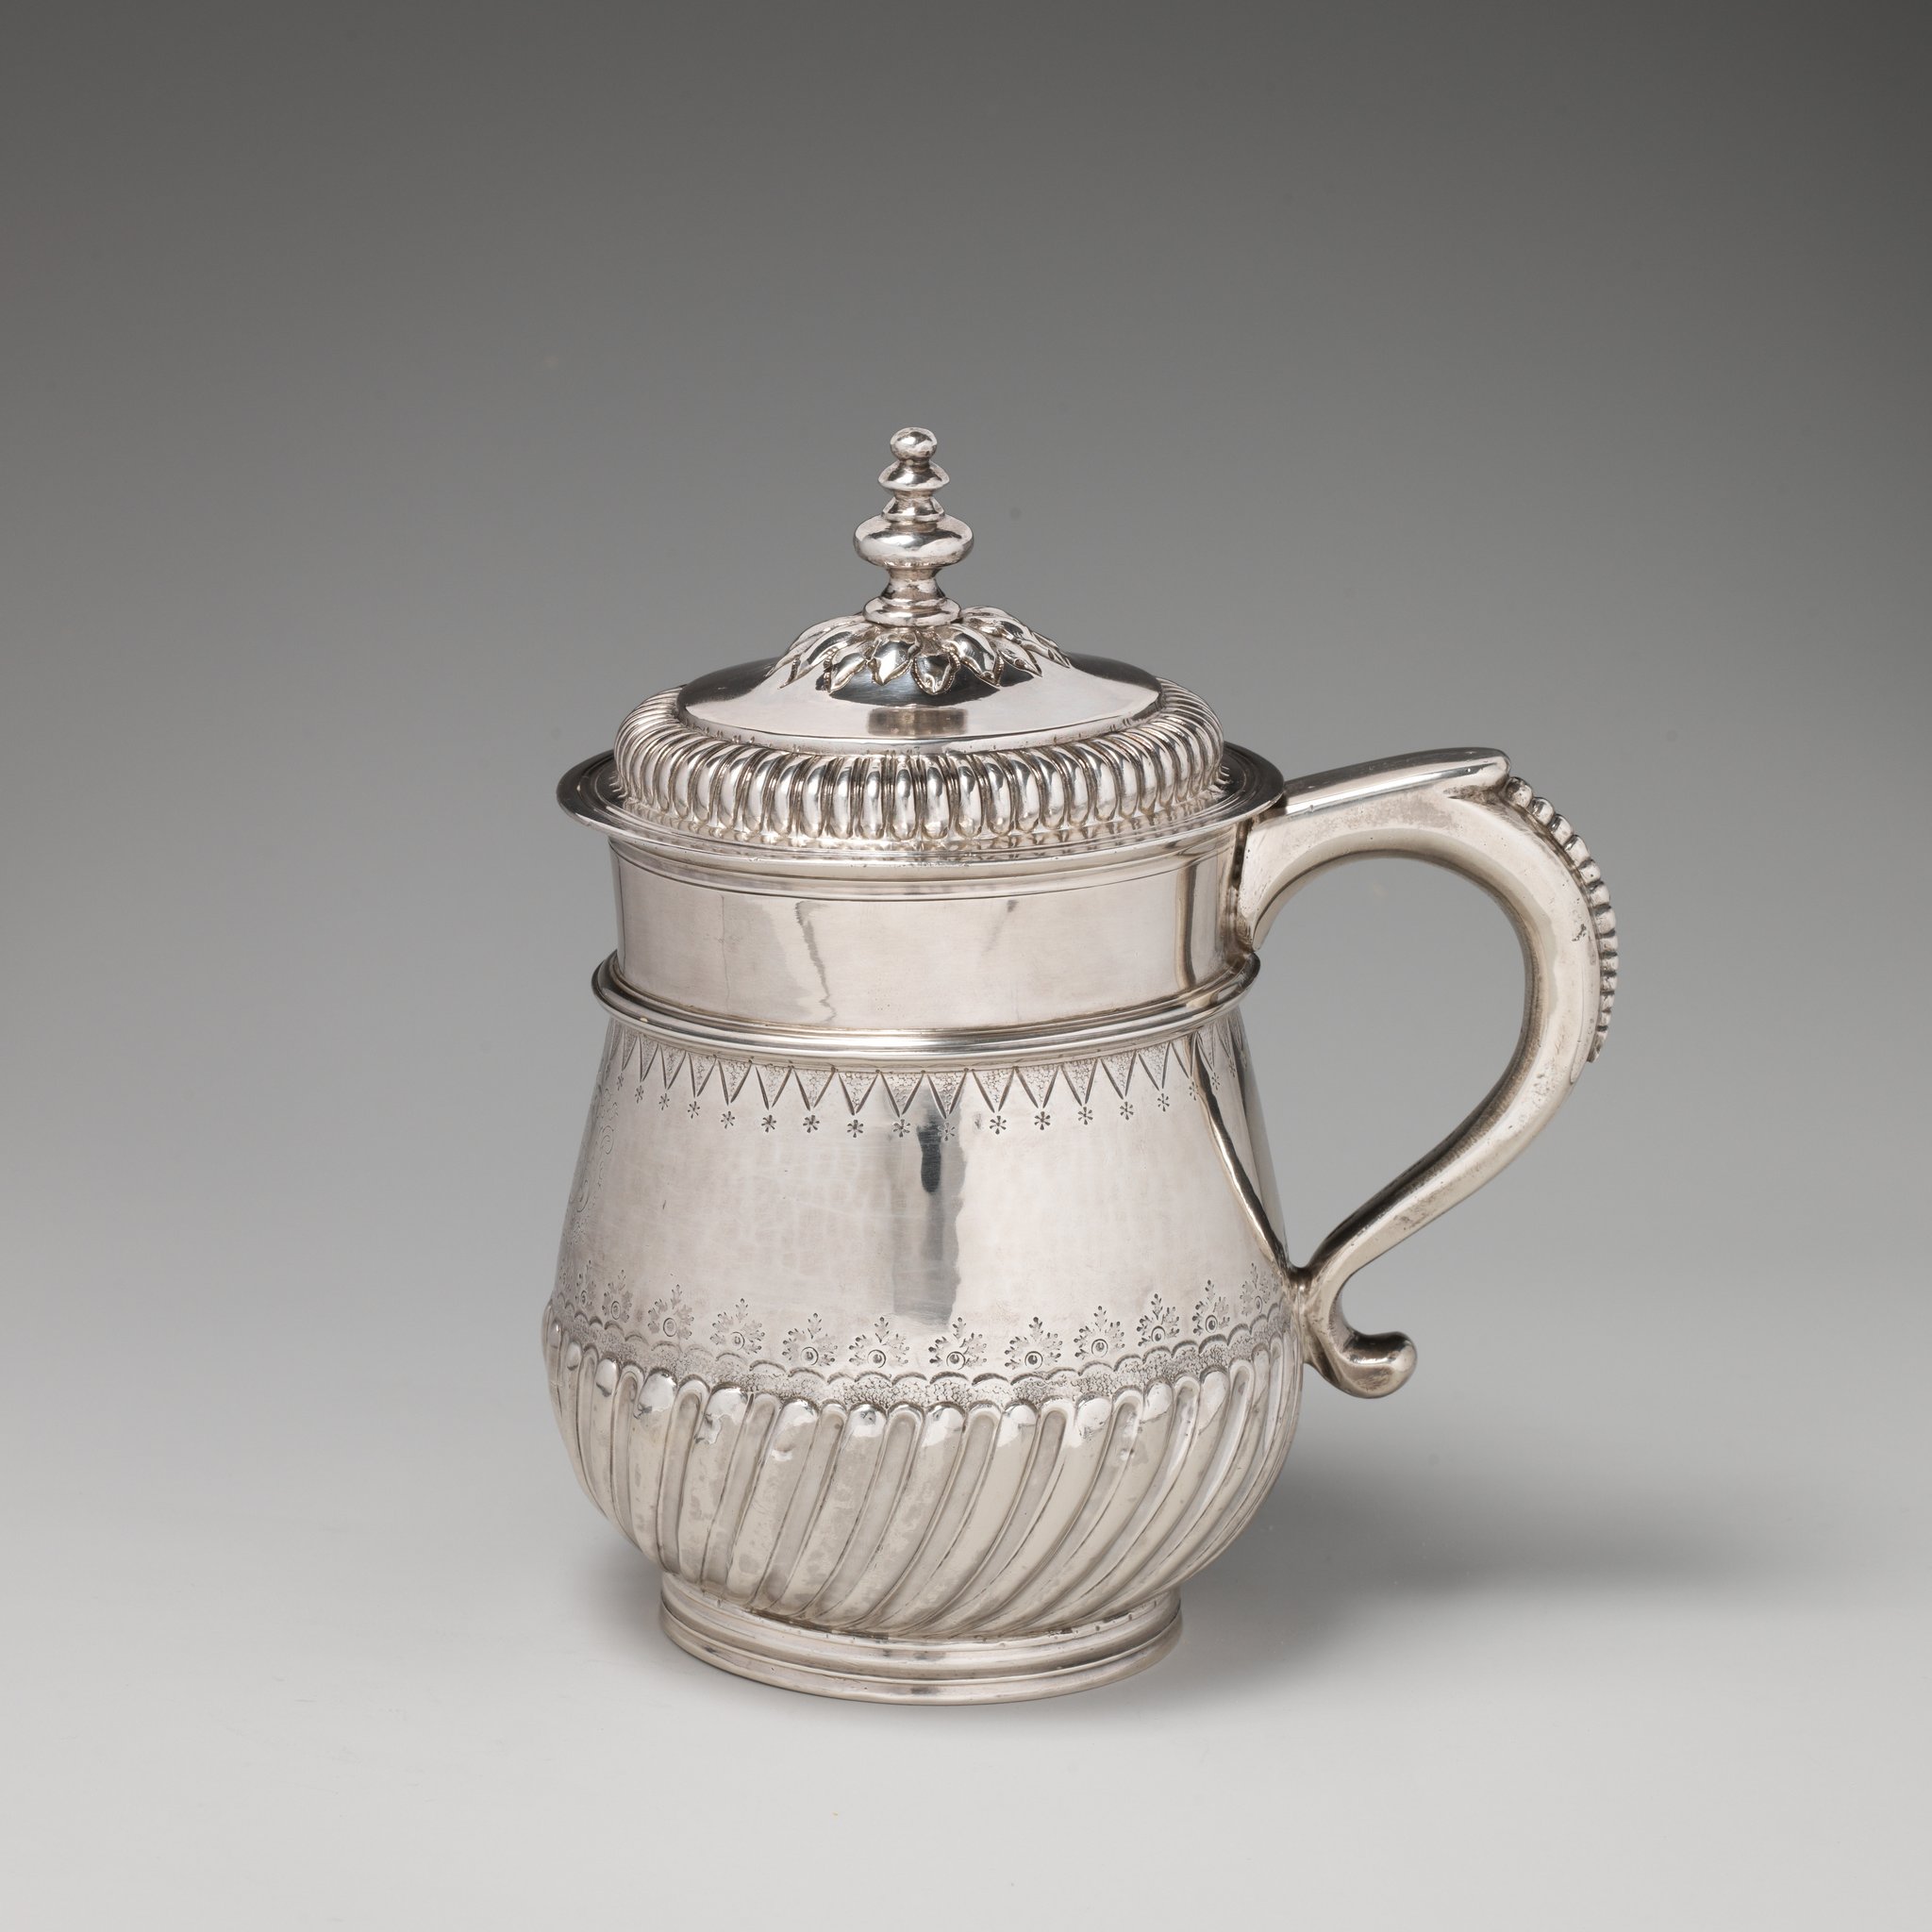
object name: mug with cover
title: Mug with cover (one of a pair)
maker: david willaume i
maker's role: maker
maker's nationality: british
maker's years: 1658-1741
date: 1702-1703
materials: silver